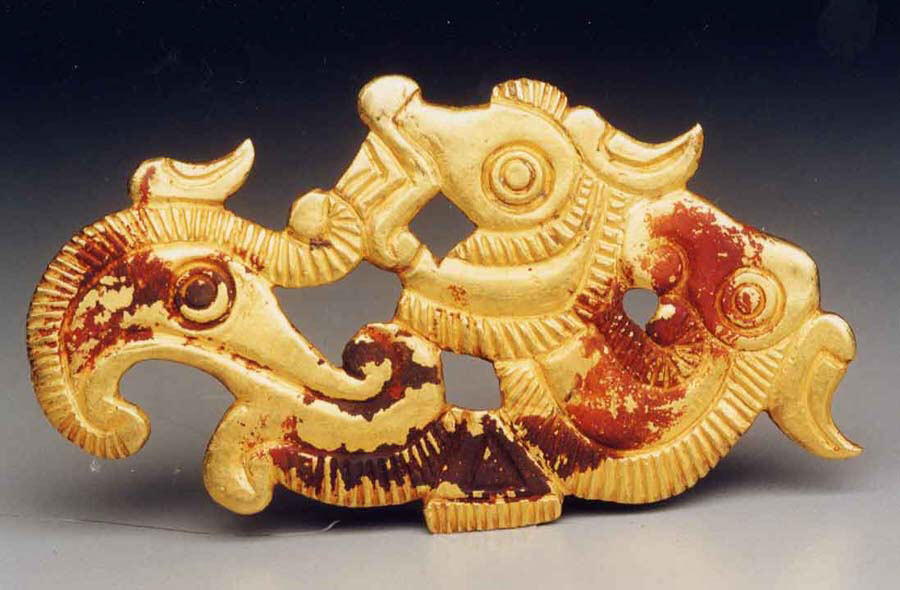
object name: bridle ornament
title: Bridle Ornament with Carnivores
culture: bulgaria or ukraine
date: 400-301 BCE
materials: gold